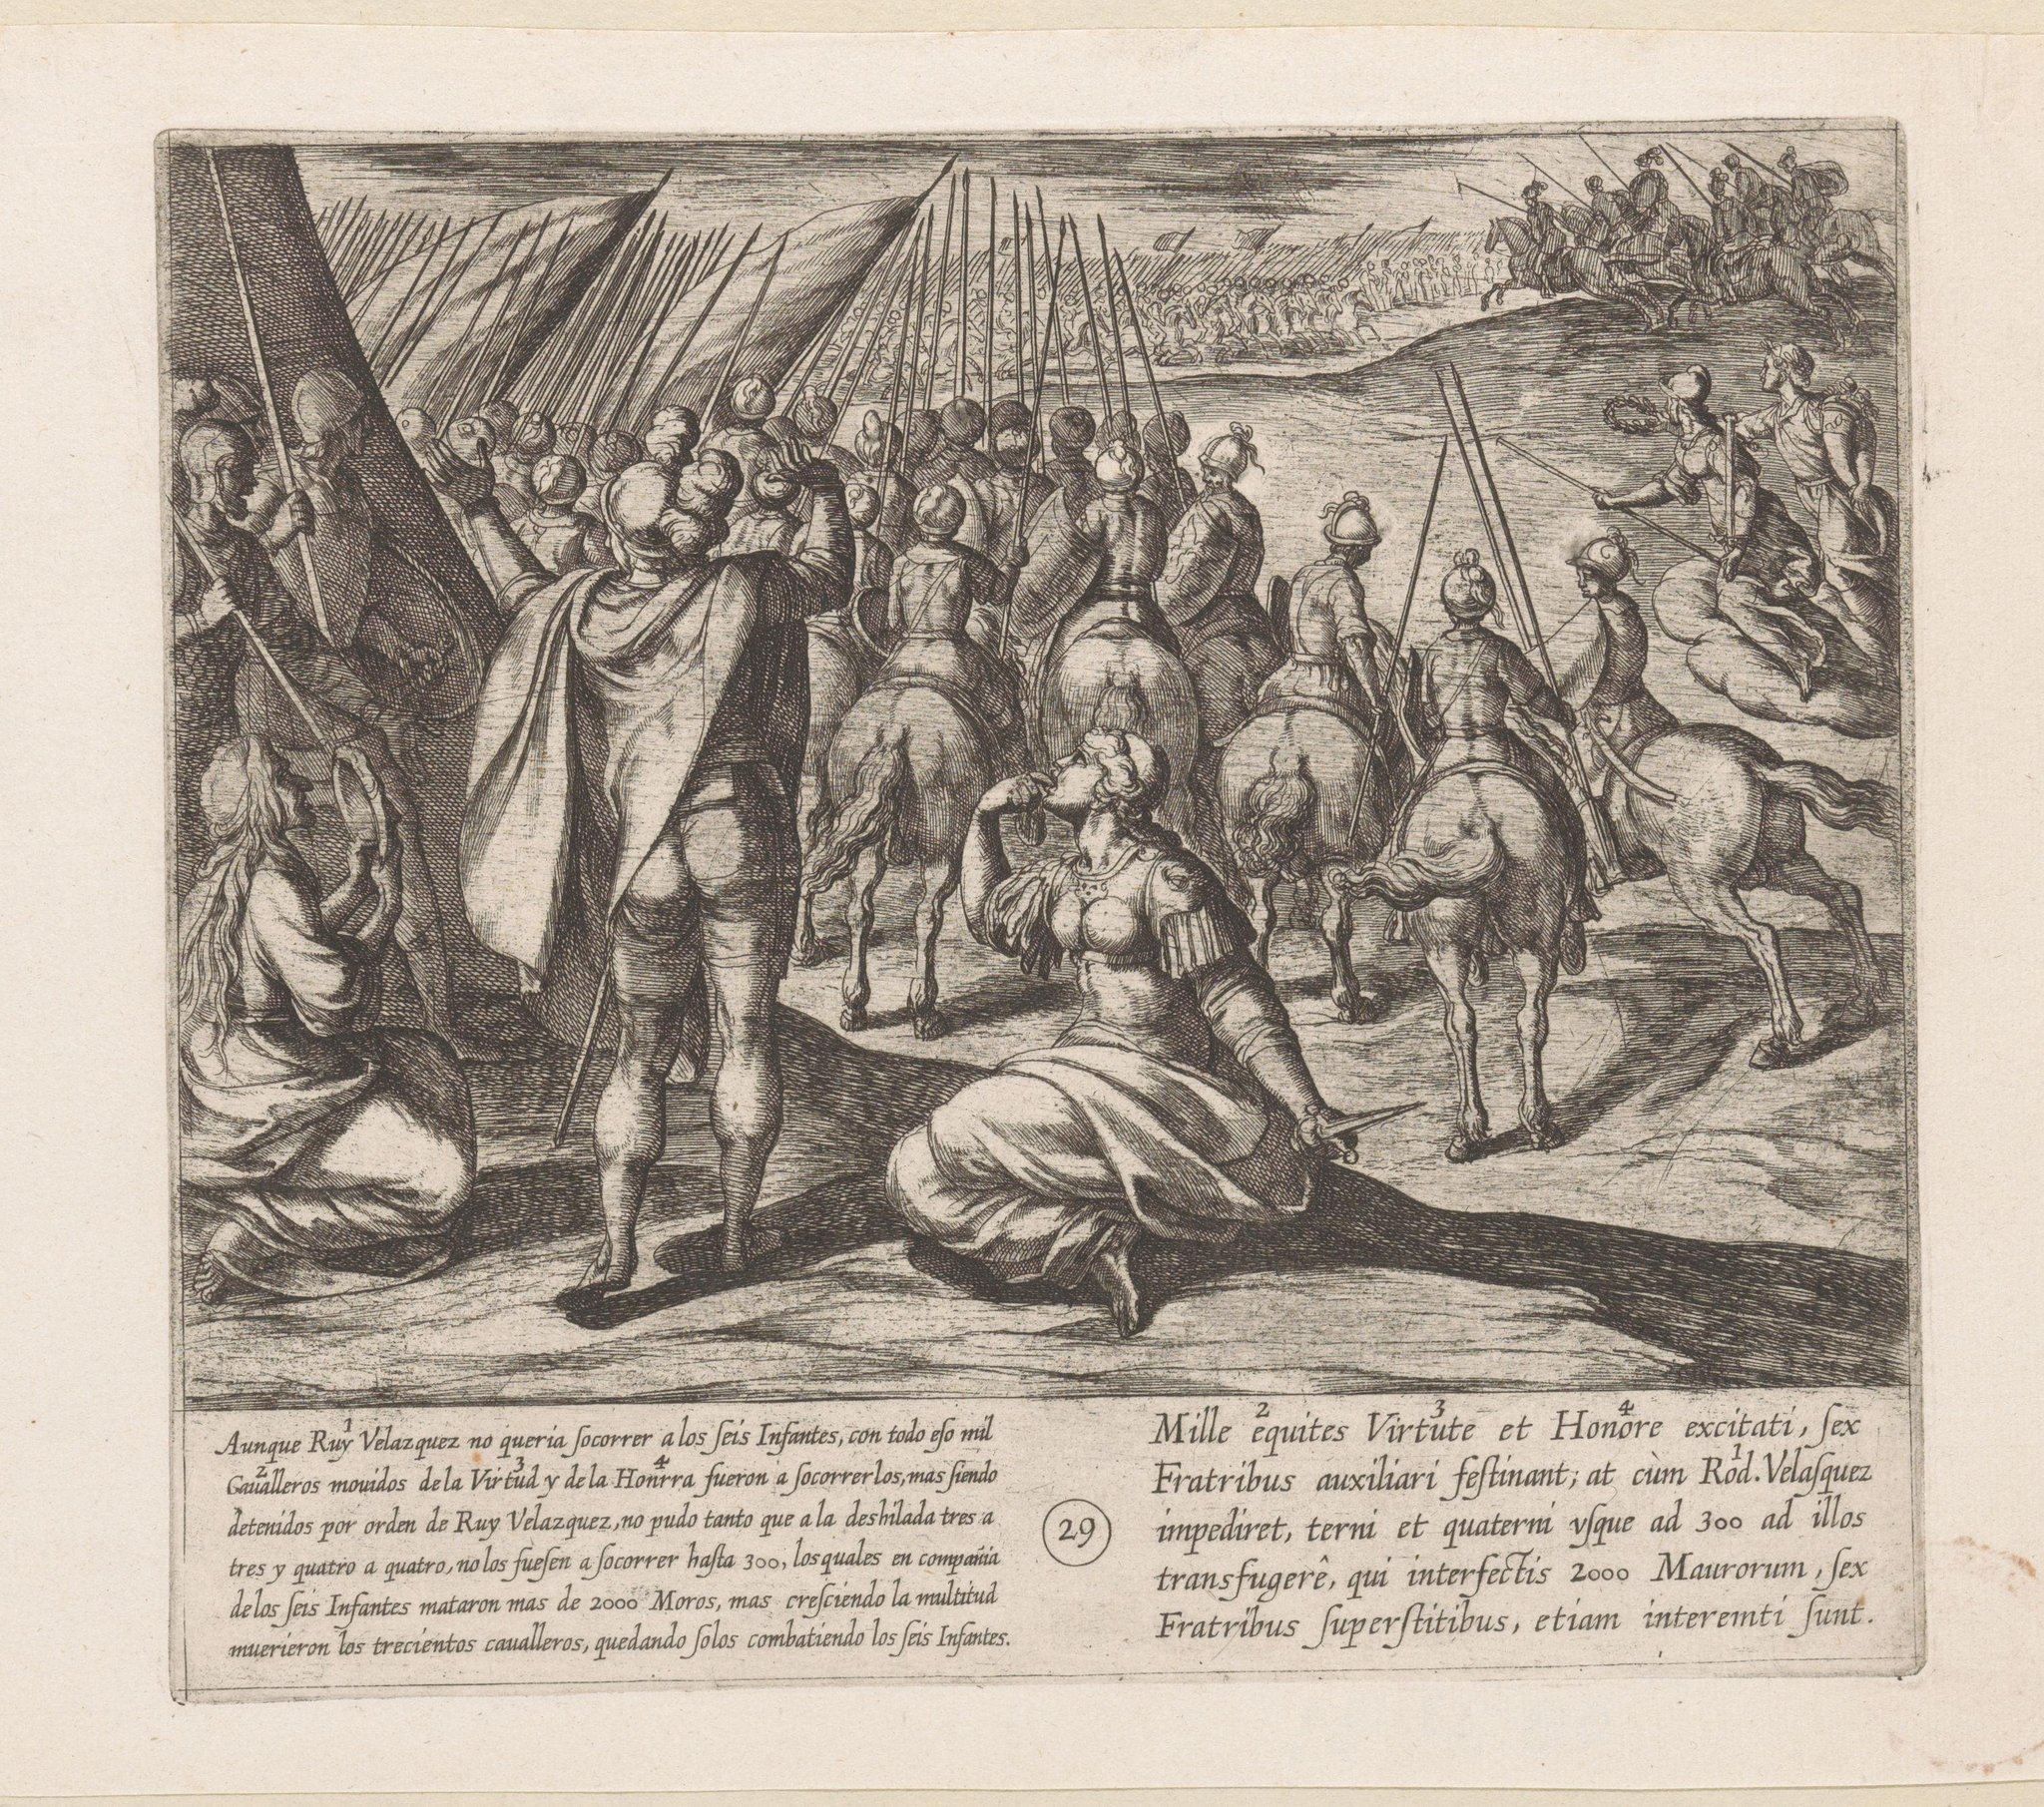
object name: print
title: Historia Septem Infantium de Lara/ Historia de los Siete Infantes de Lara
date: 1612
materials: paper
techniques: etching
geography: antwerp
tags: (military) camp with tents, warfare; military affairs (+ cavalry, horsemen), tales and fairy tales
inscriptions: collector's mark: Lugt 240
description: Deze prent maakt deel uit van een reeks van 40 prenten (+ titelprent) met voorstellingen uit het volksverhaal over de zeven infanten van Lara.